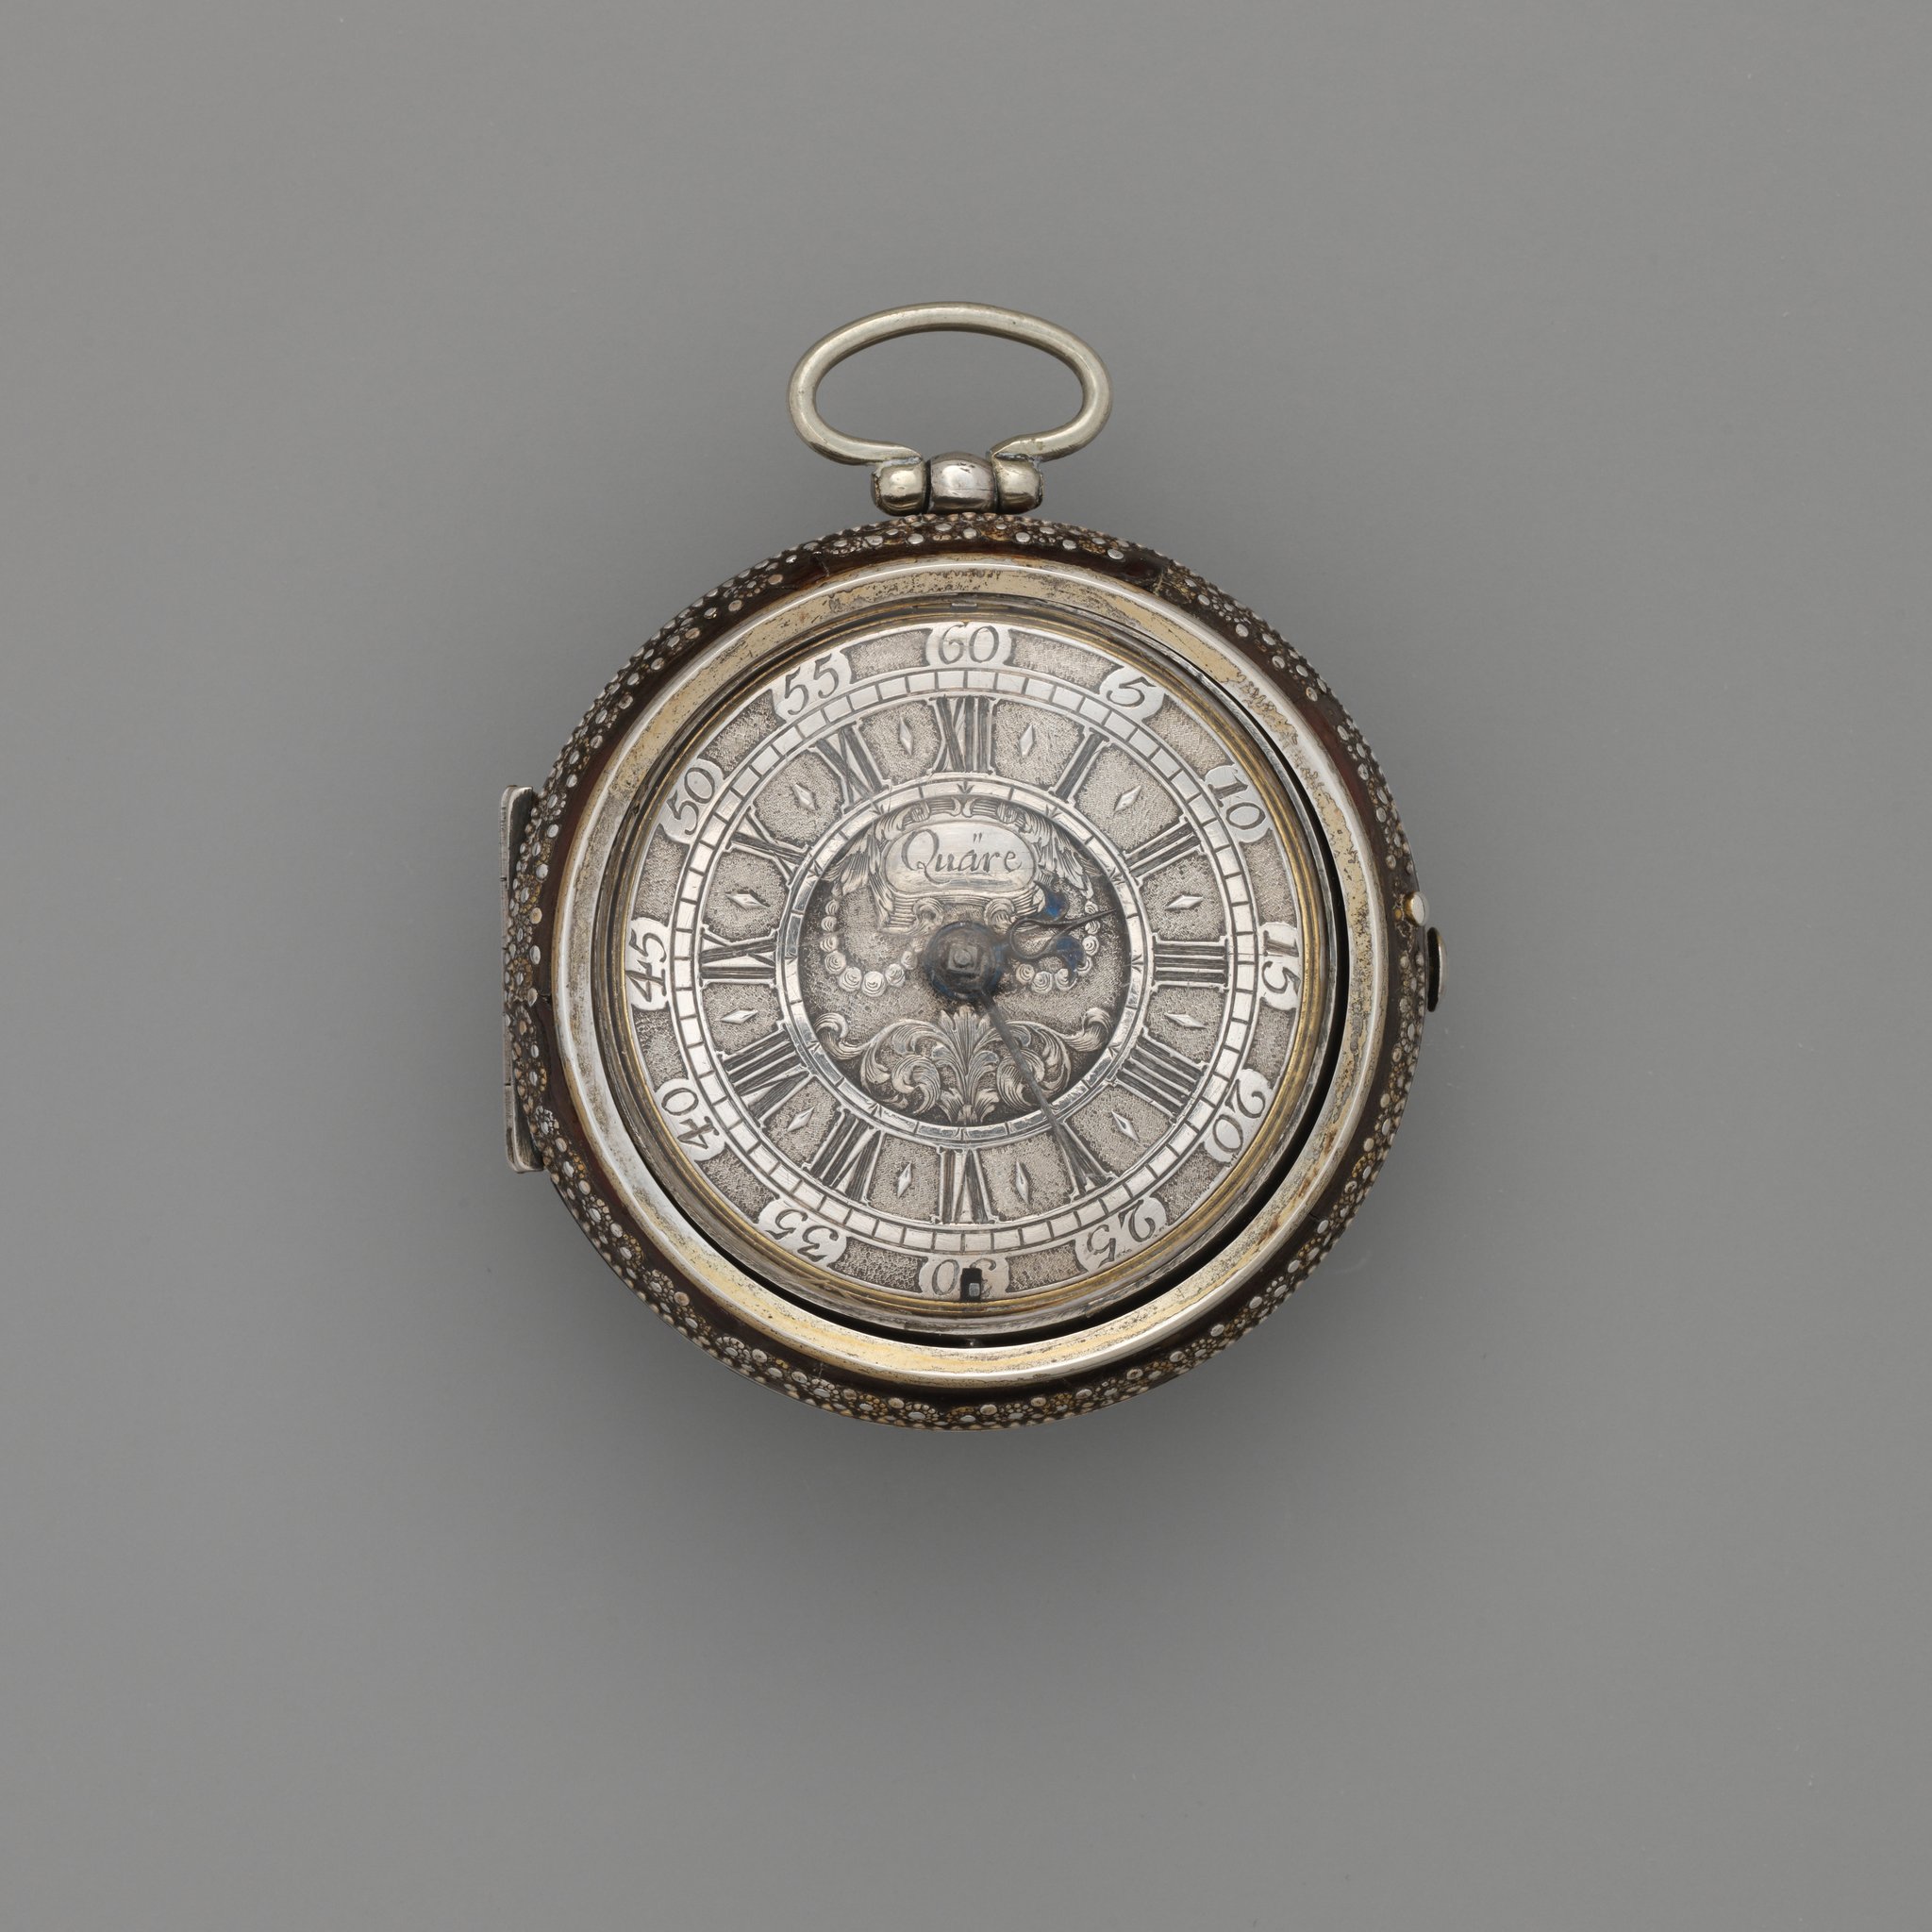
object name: pair case watch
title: Pair-case watch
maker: daniel quare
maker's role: maker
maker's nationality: british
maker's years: 1647-1724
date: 1690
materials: gold, leather, silver